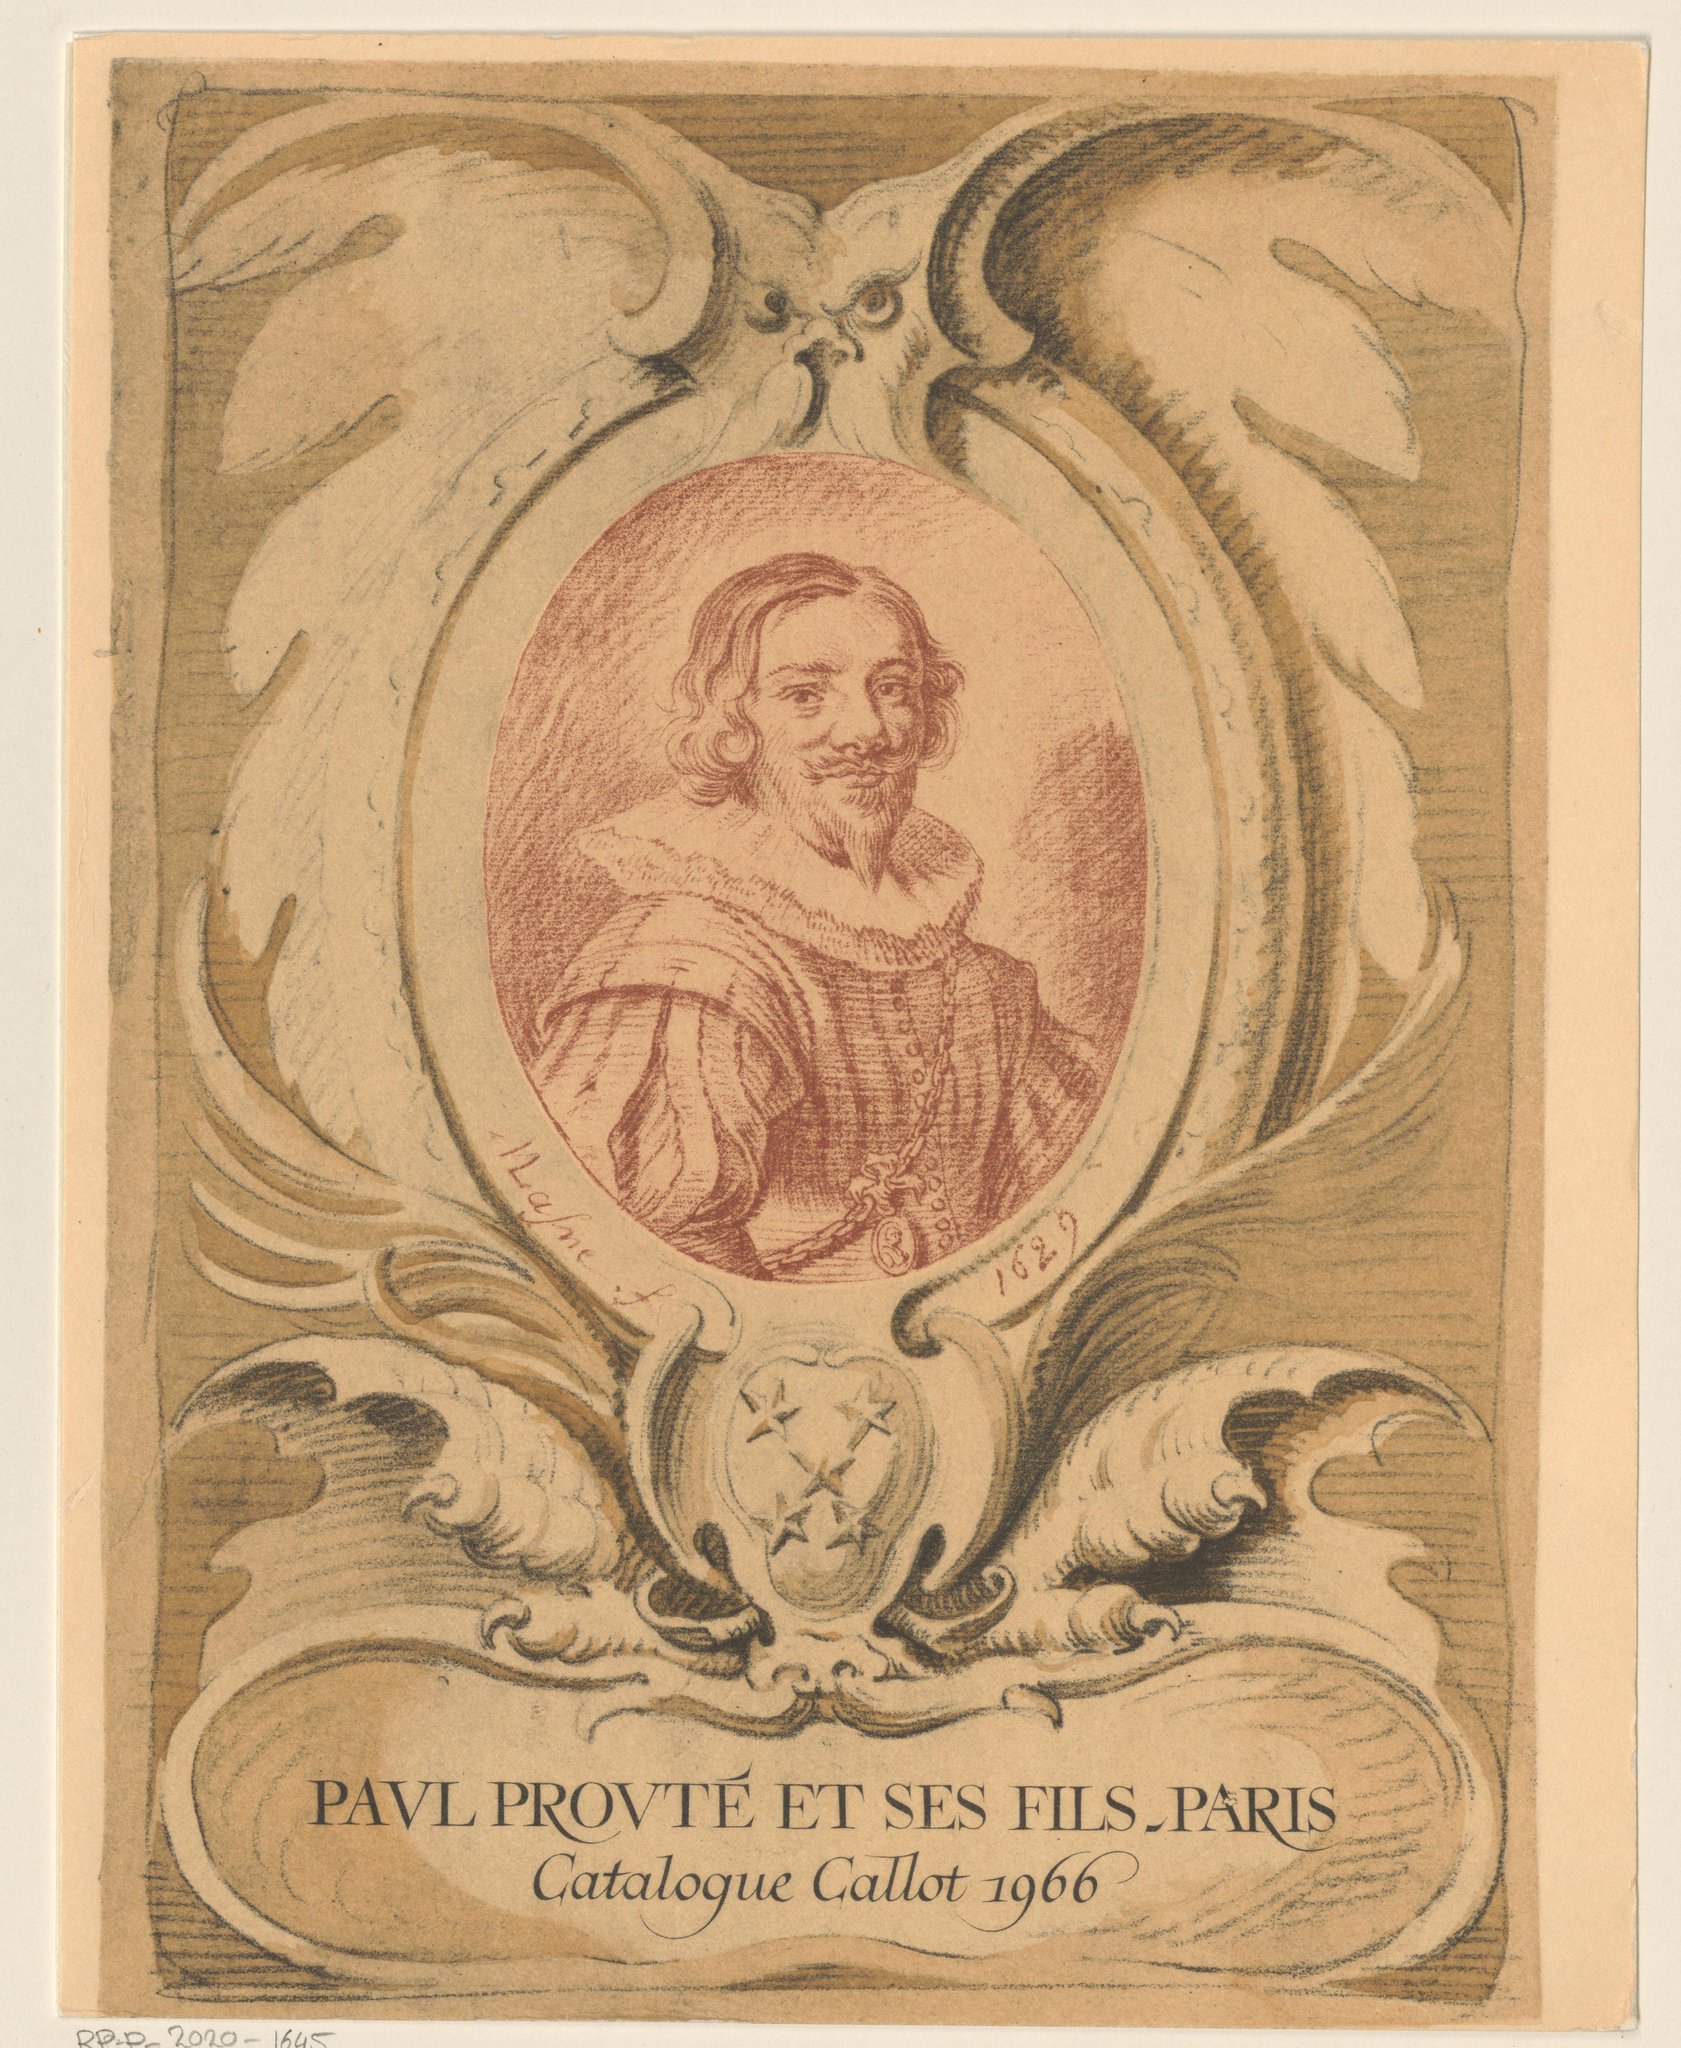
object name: print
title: Portret van Jacques Callot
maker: Anonymous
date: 1966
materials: paper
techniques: lithograph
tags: print maker, draughtsman, jacques callot, historical persons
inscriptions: date